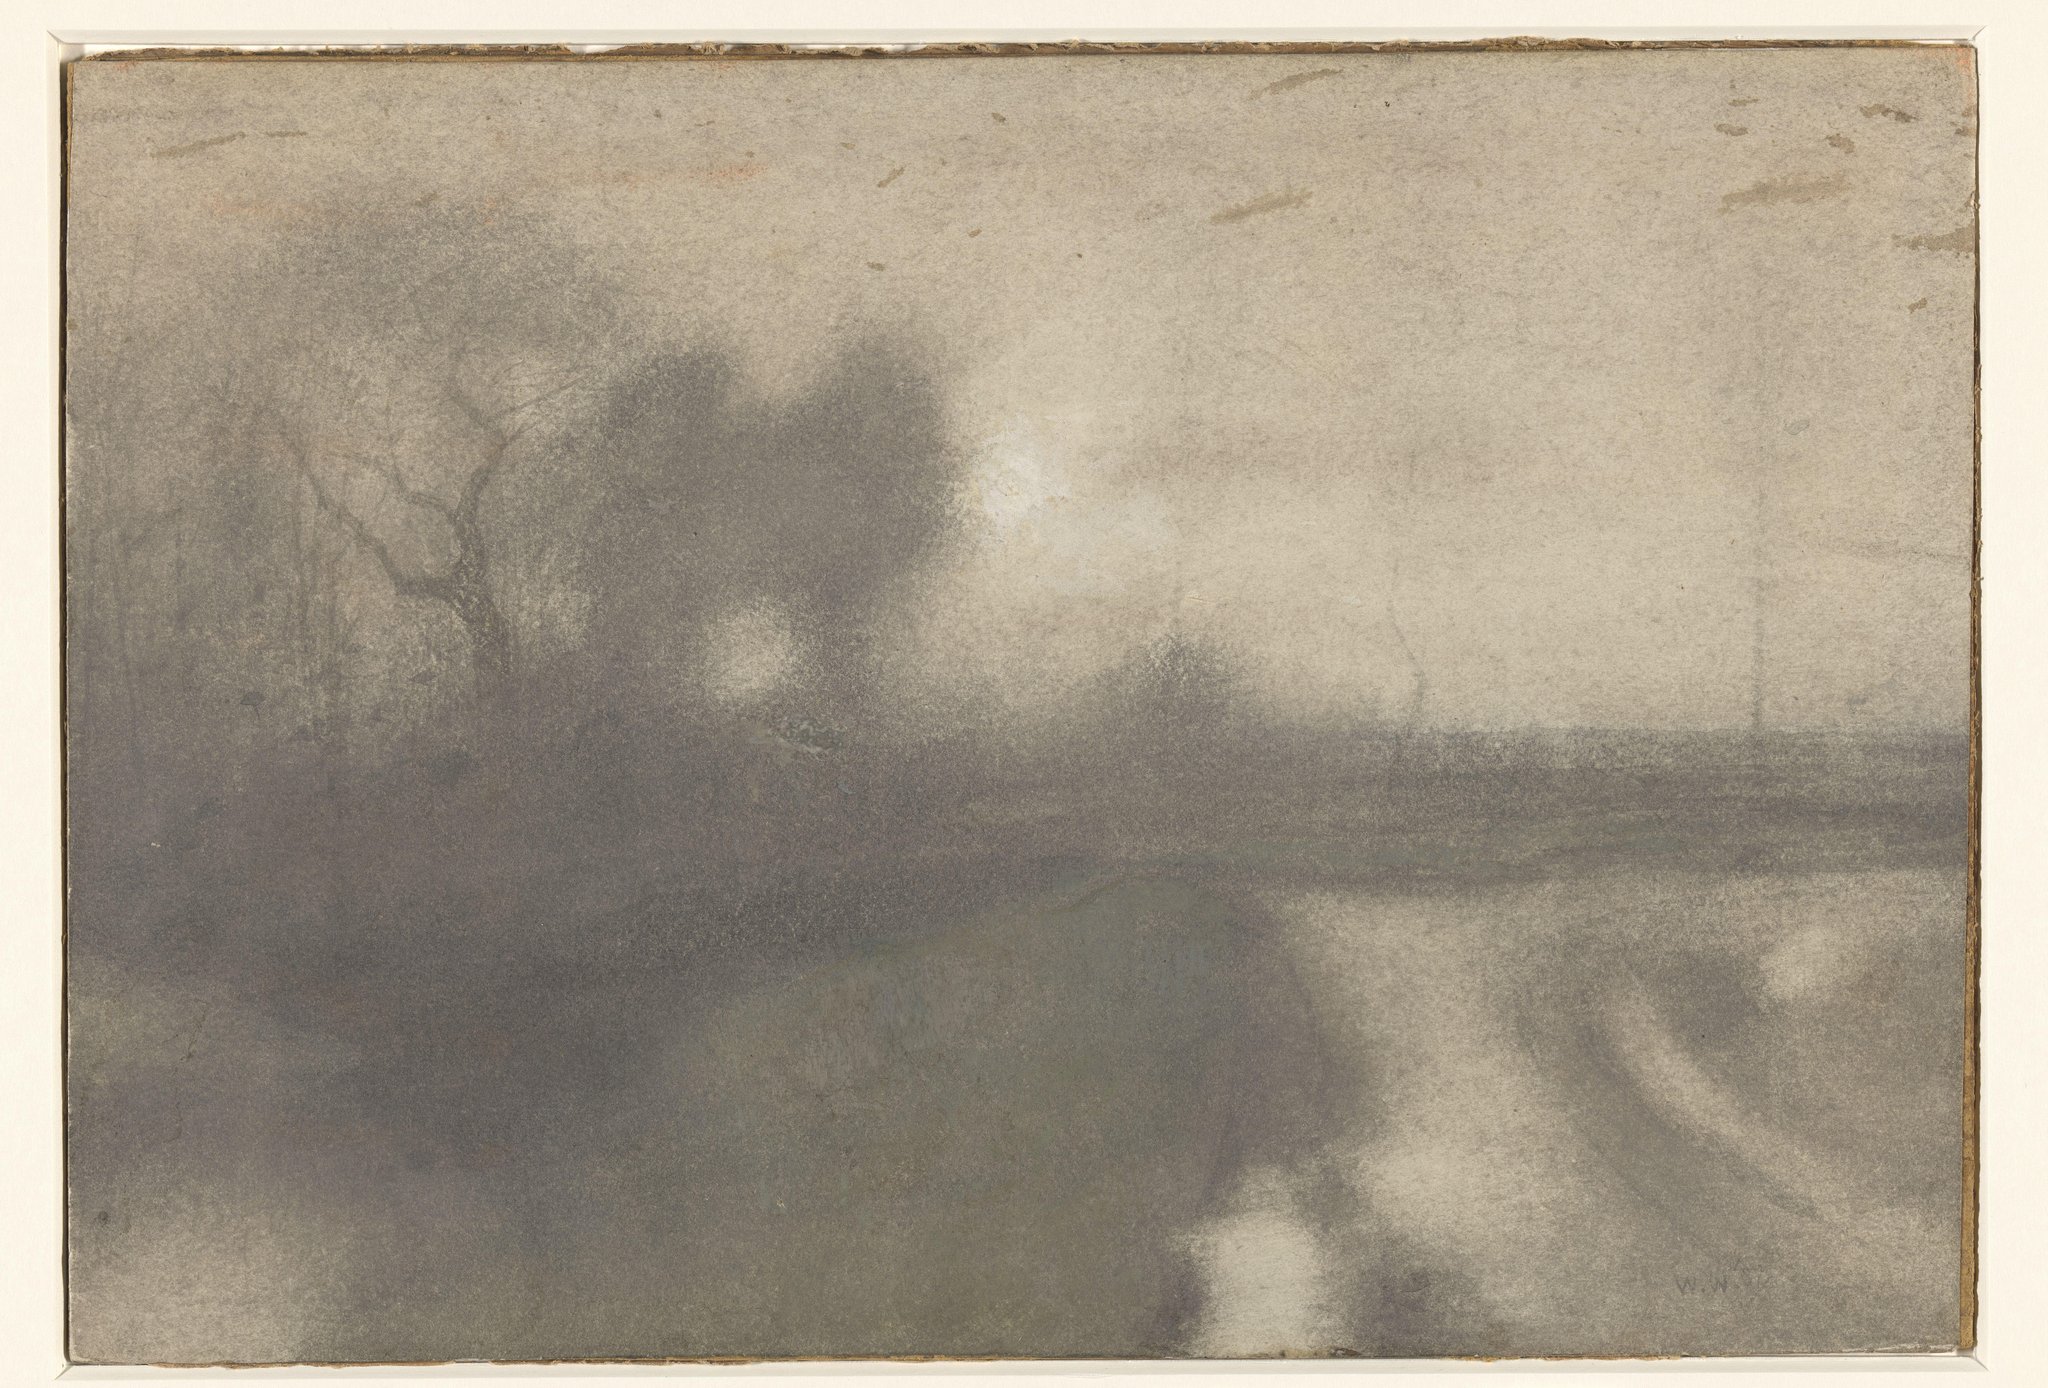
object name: drawing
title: Schemerlandschap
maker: willem witsen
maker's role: draughtsman, painter, print maker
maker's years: 1860-1923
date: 1870-1923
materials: cardboard, chalk, paper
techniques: brush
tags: dusk, evening twilight, landscapes